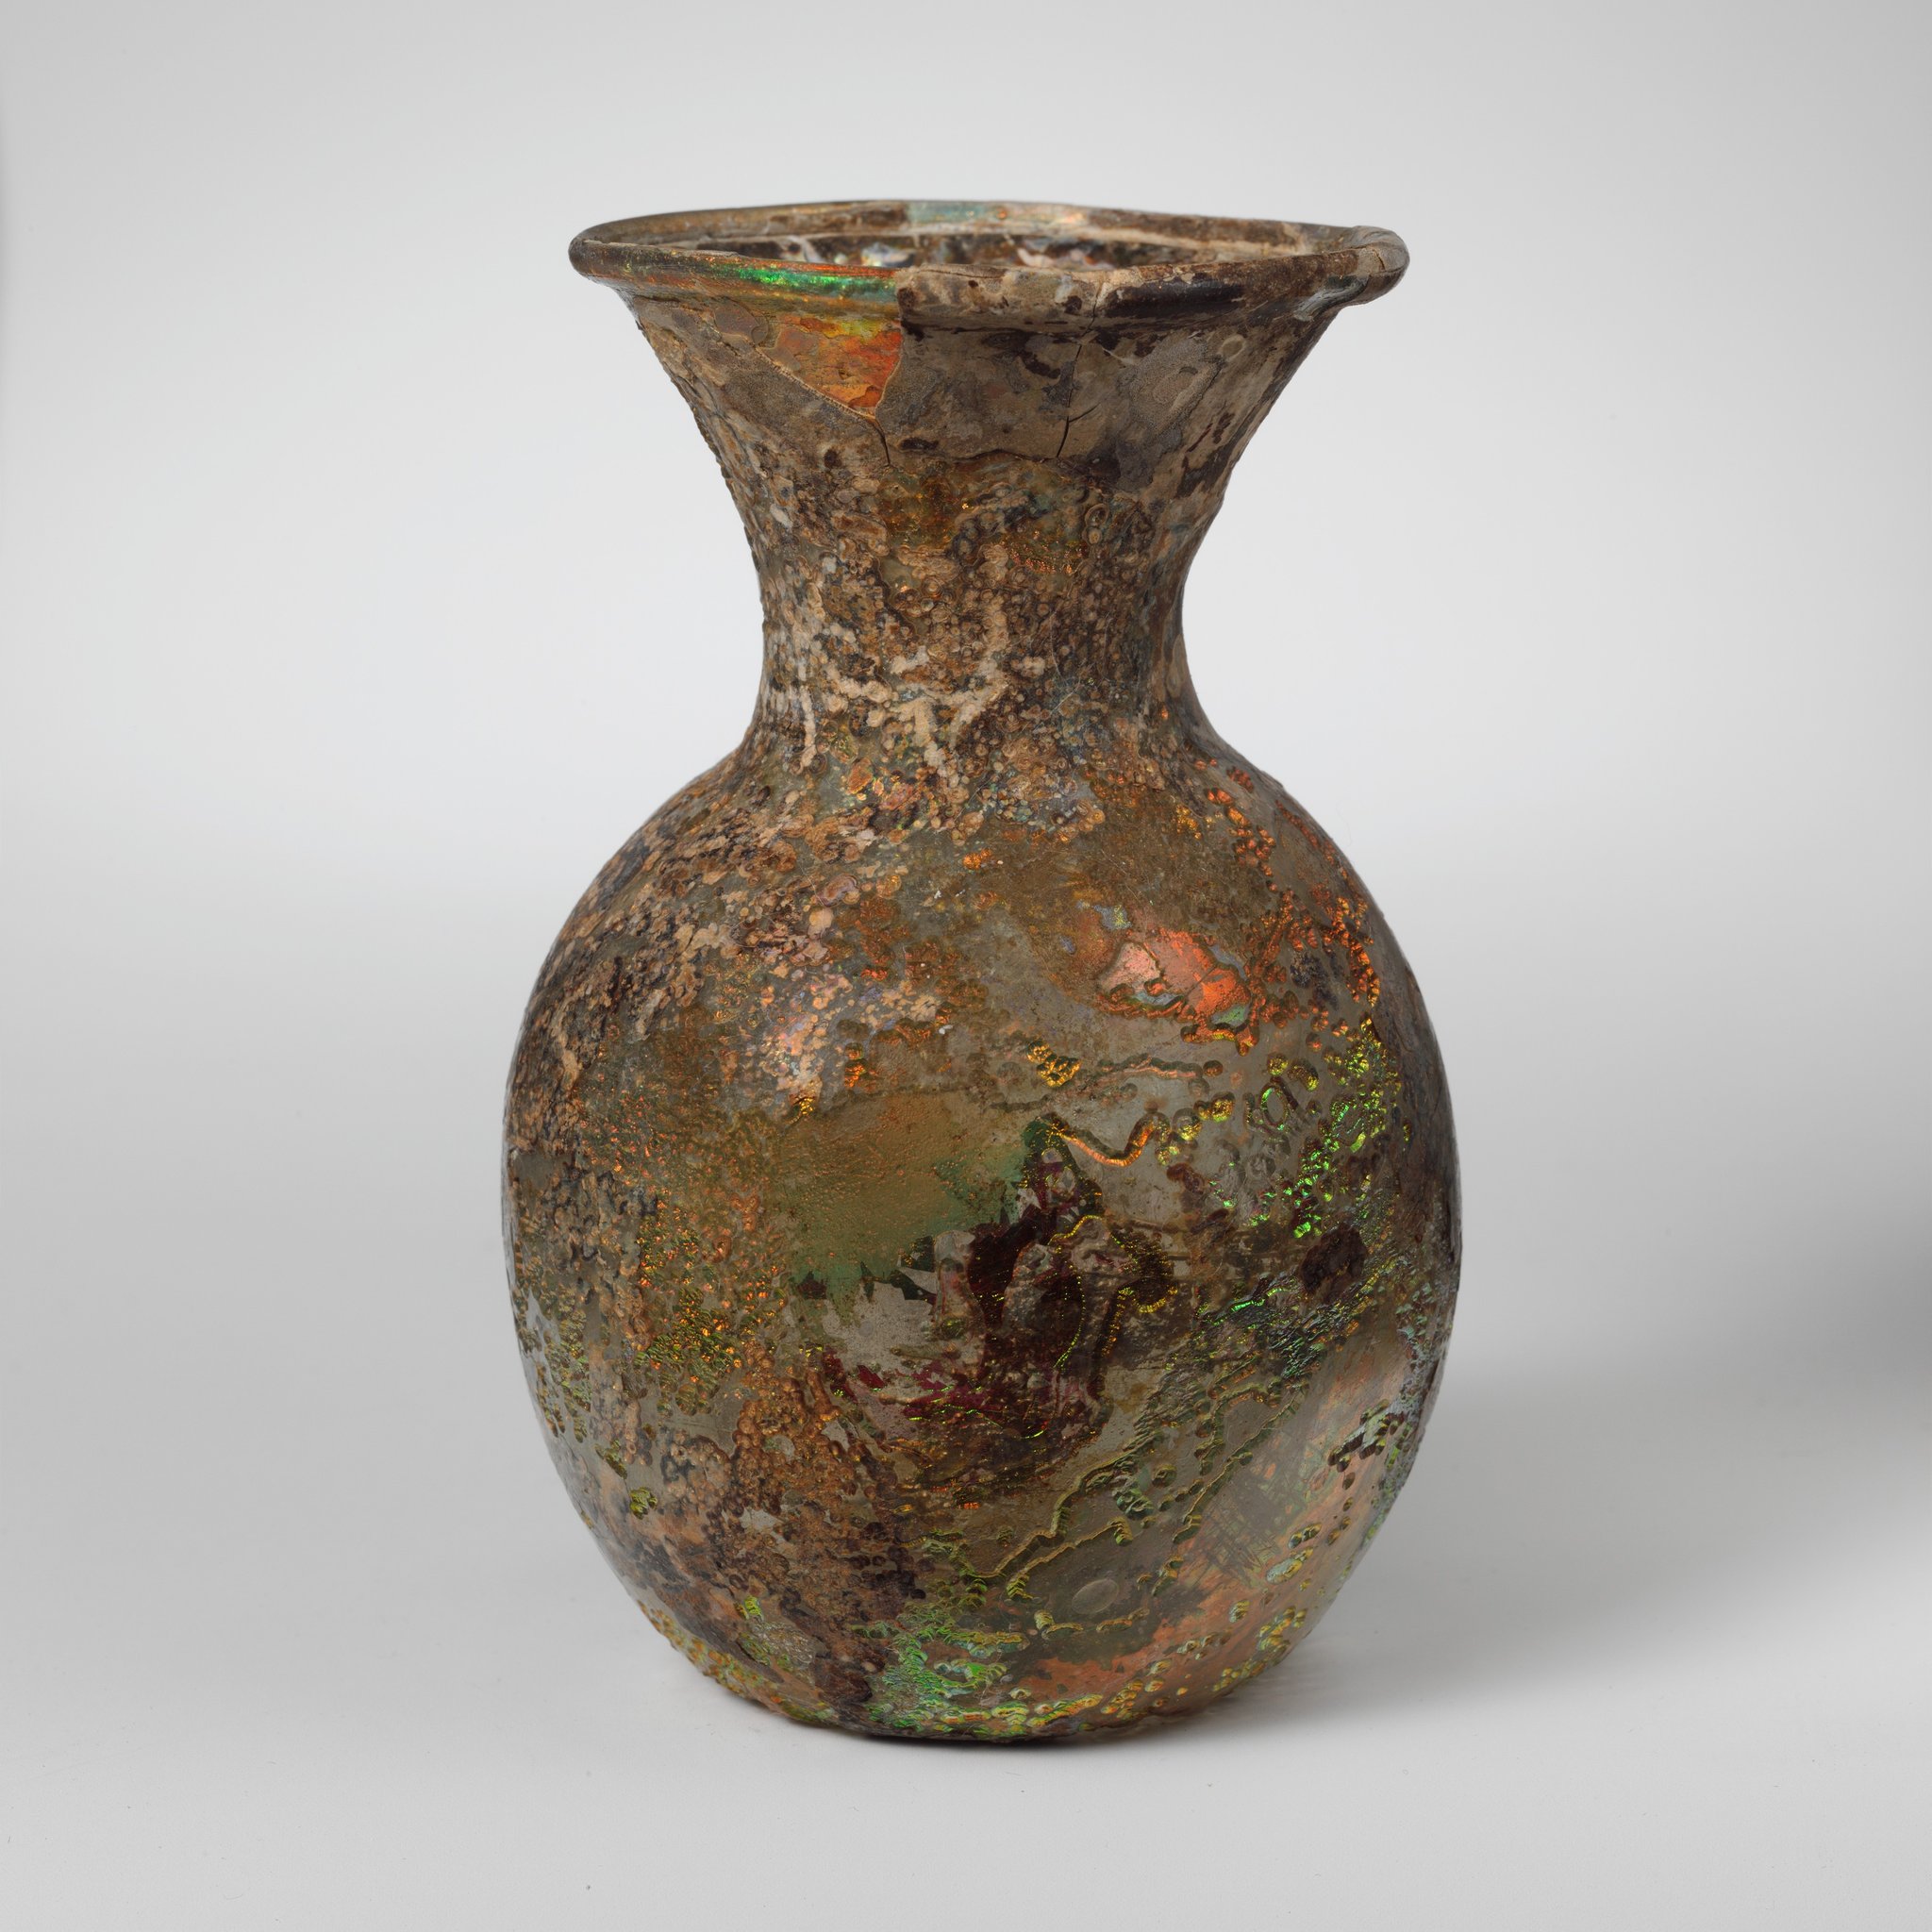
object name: flask or jar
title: Glass flask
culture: roman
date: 234-400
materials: glass